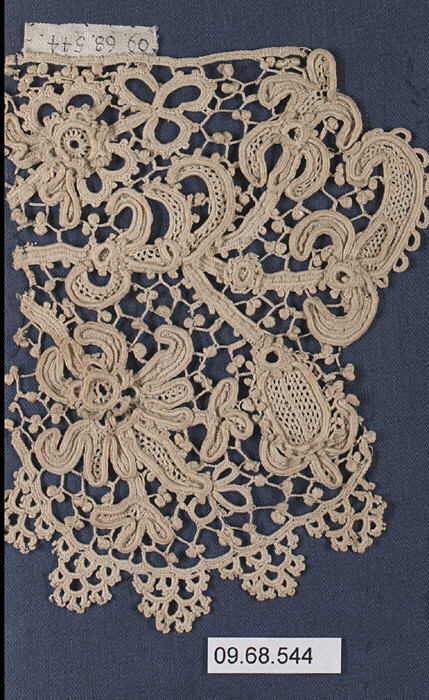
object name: specimen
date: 1801-1900